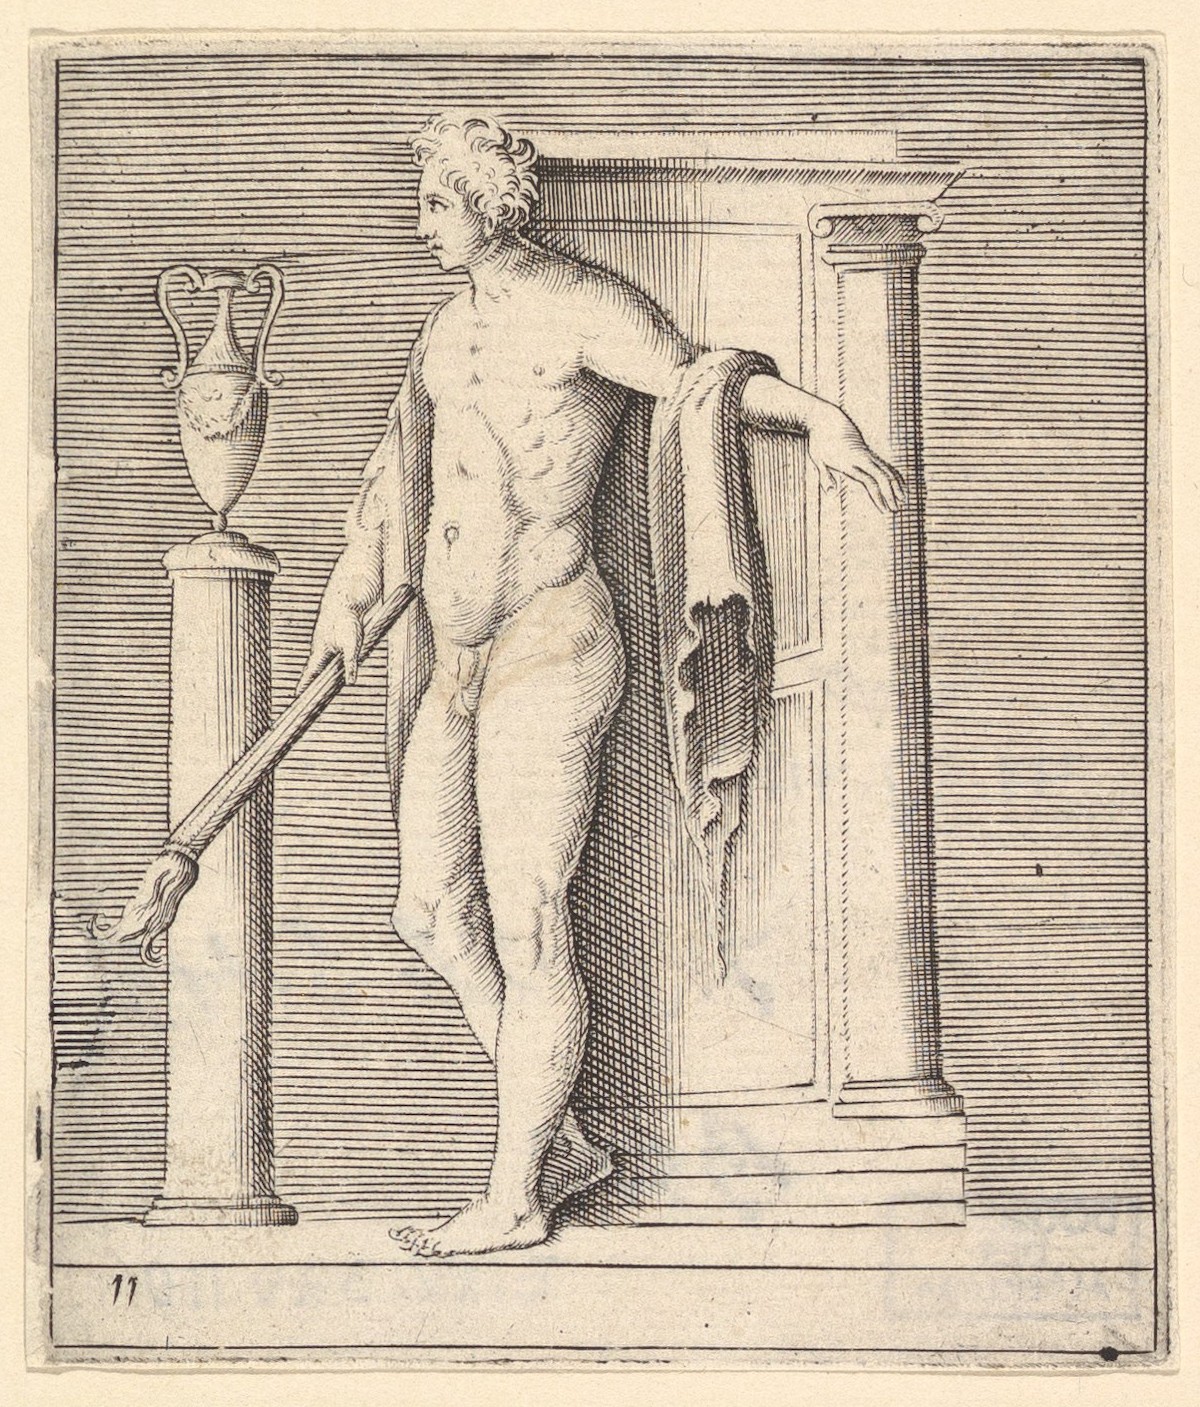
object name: print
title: Man with Torch at Temple Door, from "Ex Antiquis Cameorum et Gemmae Delineata/ Liber Secundus/et ab Enea Vico Parmen Incis"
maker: anonymous, italian, 16th century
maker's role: artist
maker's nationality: italian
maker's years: 1500-1600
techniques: engraving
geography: rome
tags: male nudes